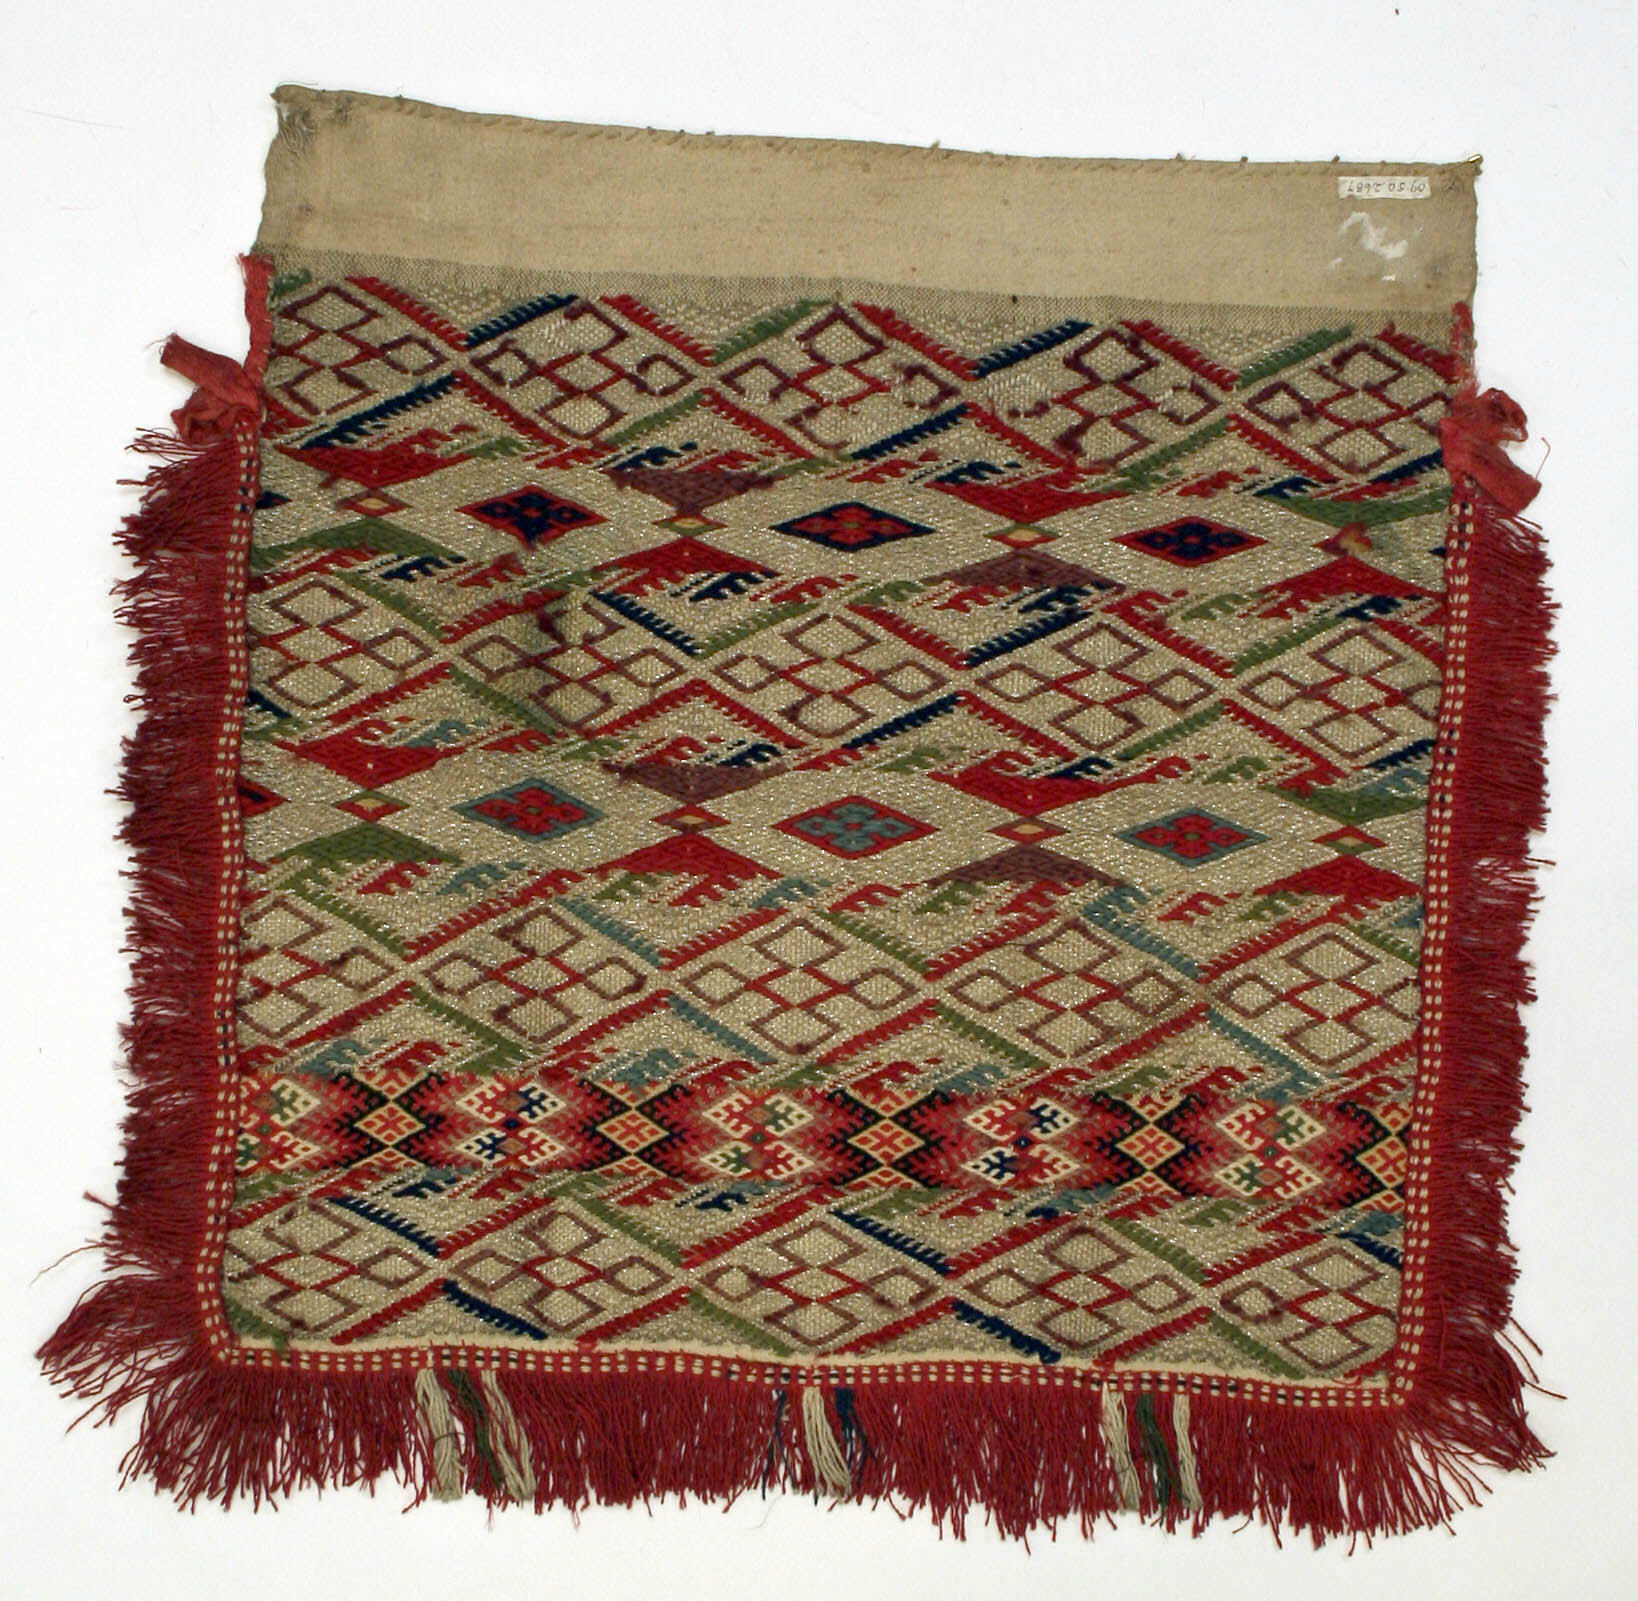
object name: apron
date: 1801-1900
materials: wool